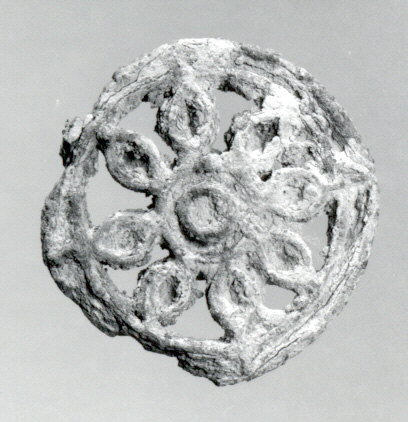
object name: stamp seal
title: Compartmented stamp seal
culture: bactria-margiana archaeological complex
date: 2333-1668 BCE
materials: copper alloy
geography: bactria-margiana